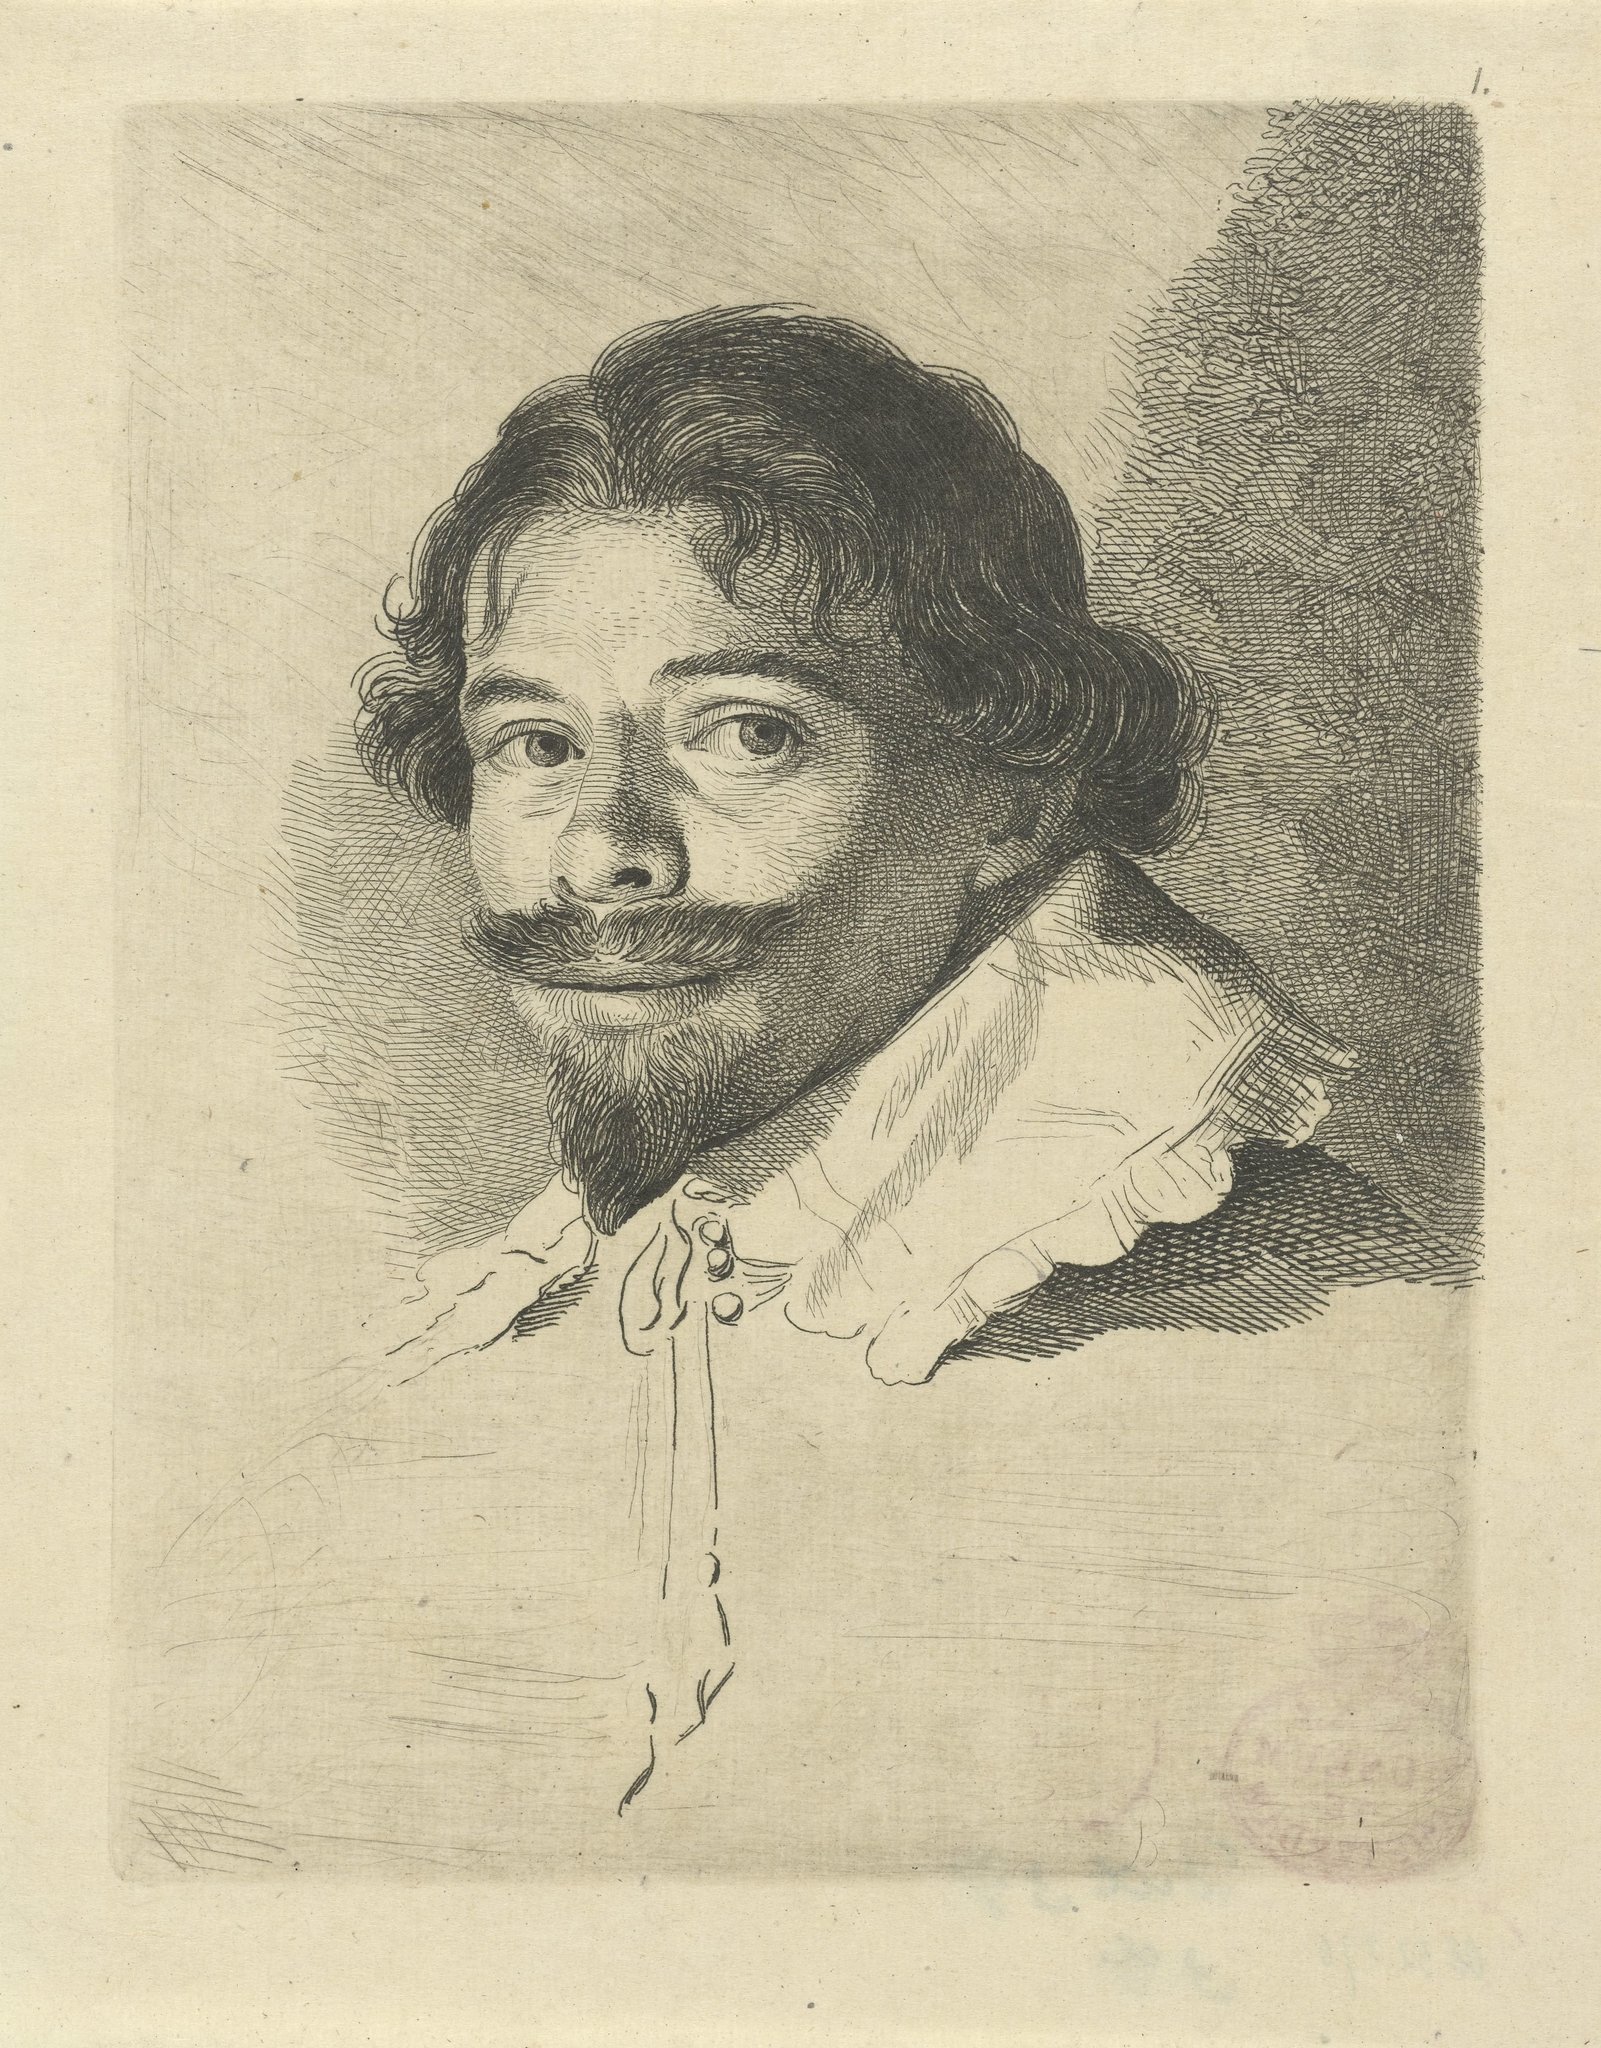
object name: print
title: Portret van David Bailly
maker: johannes pieter de frey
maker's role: draughtsman, print maker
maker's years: 1770-1834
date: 1801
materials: paper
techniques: etching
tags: leiden, david bailly, portrait, self-portrait of artist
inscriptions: collector's mark: Lugt 12, number: ‘1’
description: Portret van de schilder en tekenaar David Bailly, portretbuste naar links.